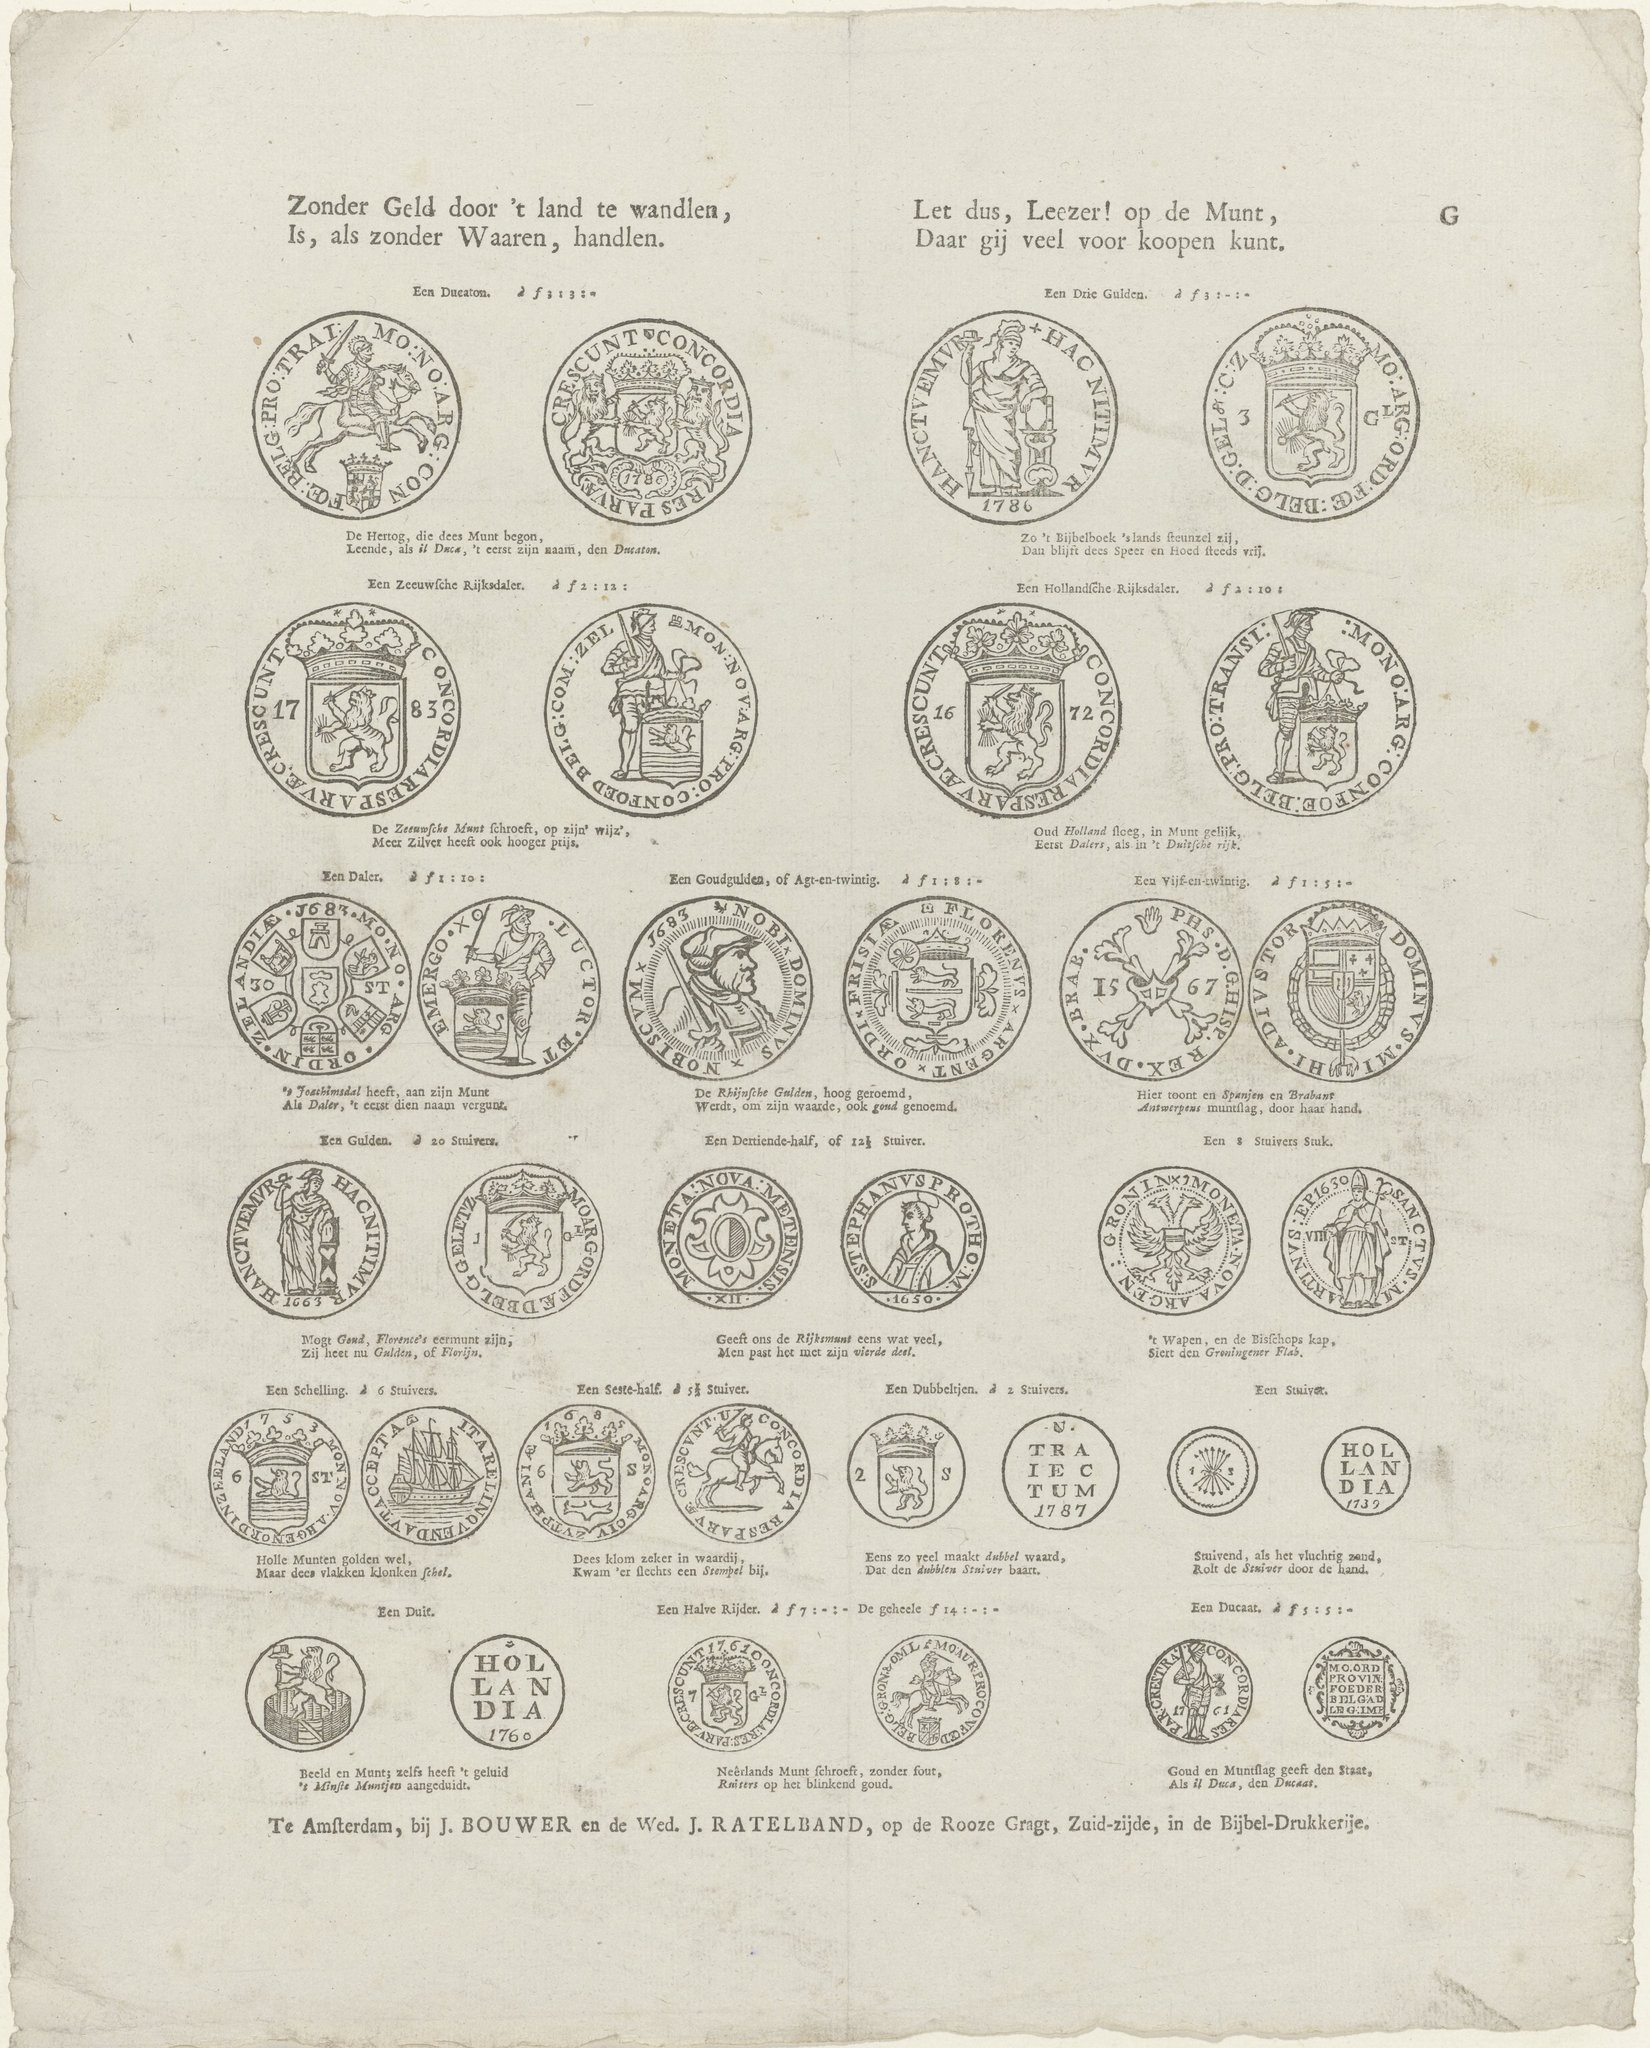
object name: popular print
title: Zonder geld door 't land te wandlen, / Is als zonder waaren, handlen. / Let dus, leezer! op de munt, / Daar gij veel voor koopen kunt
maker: Anonymous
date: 1794-1804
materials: paper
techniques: letterpress printing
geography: netherlands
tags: coin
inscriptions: collector's mark: Lugt 2760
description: Blad met 17 voorstellingen van oude Nederlandse munten, voor- en keerzijde. Boven elke voorstelling de naam en waarde van de munt, eronder een tweeregelig vers. Genummerd rechtsboven: G.